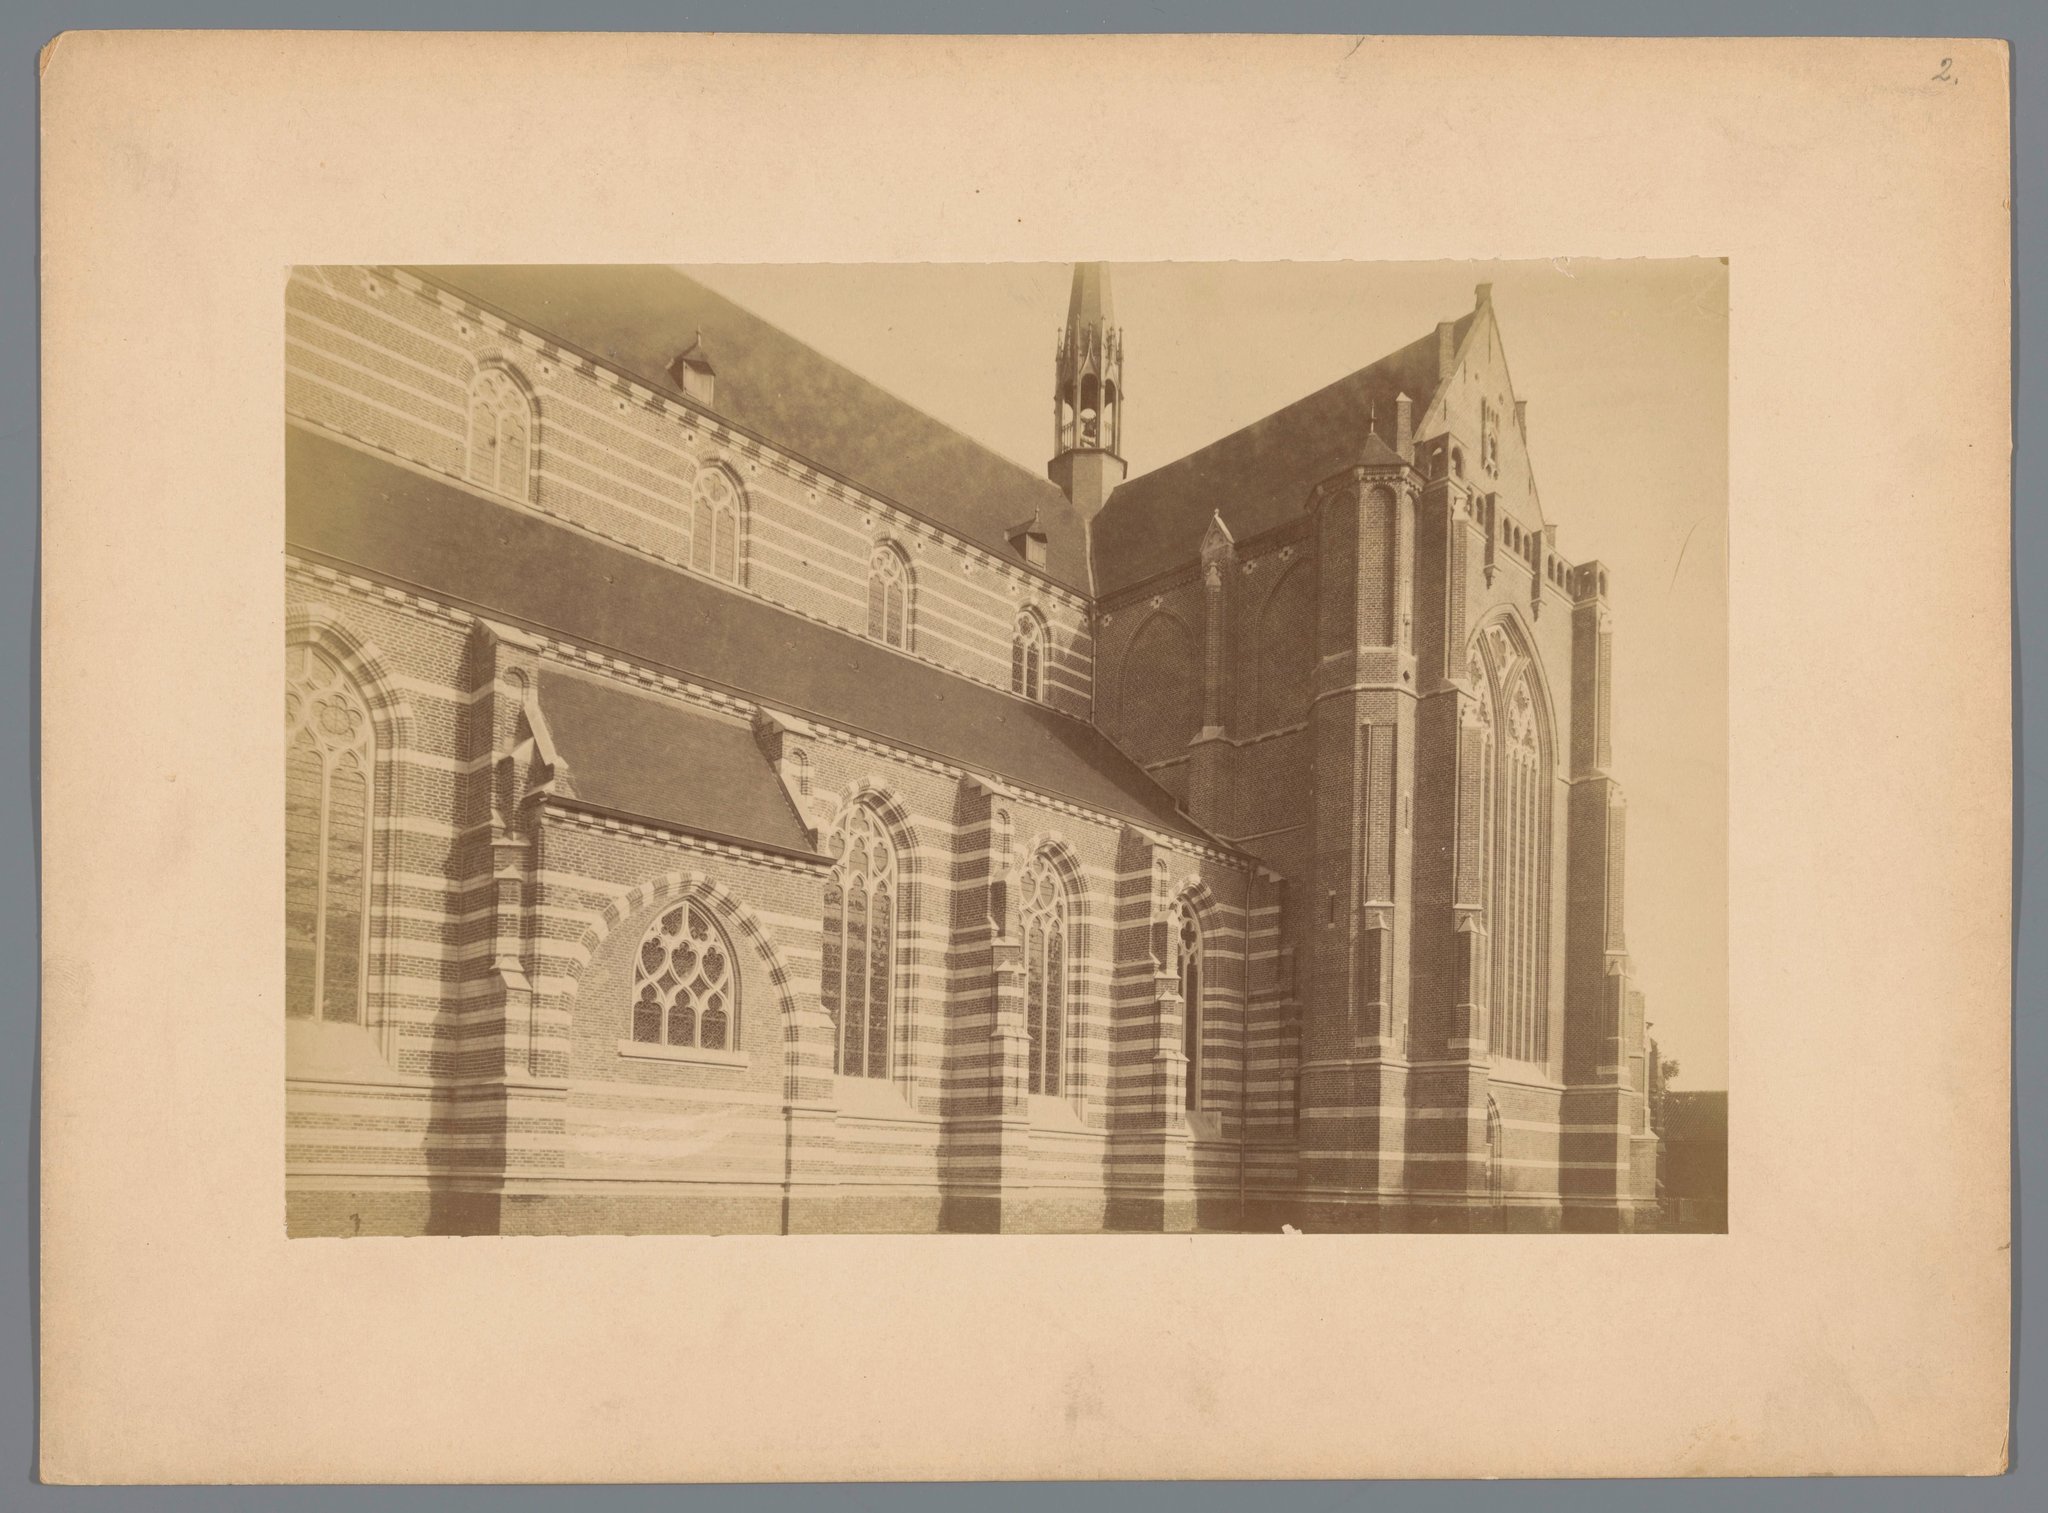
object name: photograph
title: Exterieur van de Sint-Petrusbasiliek te Oirschot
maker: Anonymous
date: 1887-1900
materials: cardboard, photographic support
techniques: albumen print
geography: oirschot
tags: church (exterior), façade (of house or building)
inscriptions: inscription: ‘Oorschot. R.K. Kerk na de restauratie’, collector's mark: ‘Rijks-Normaalschool voor Teekenonderwijzers Amsterdam’